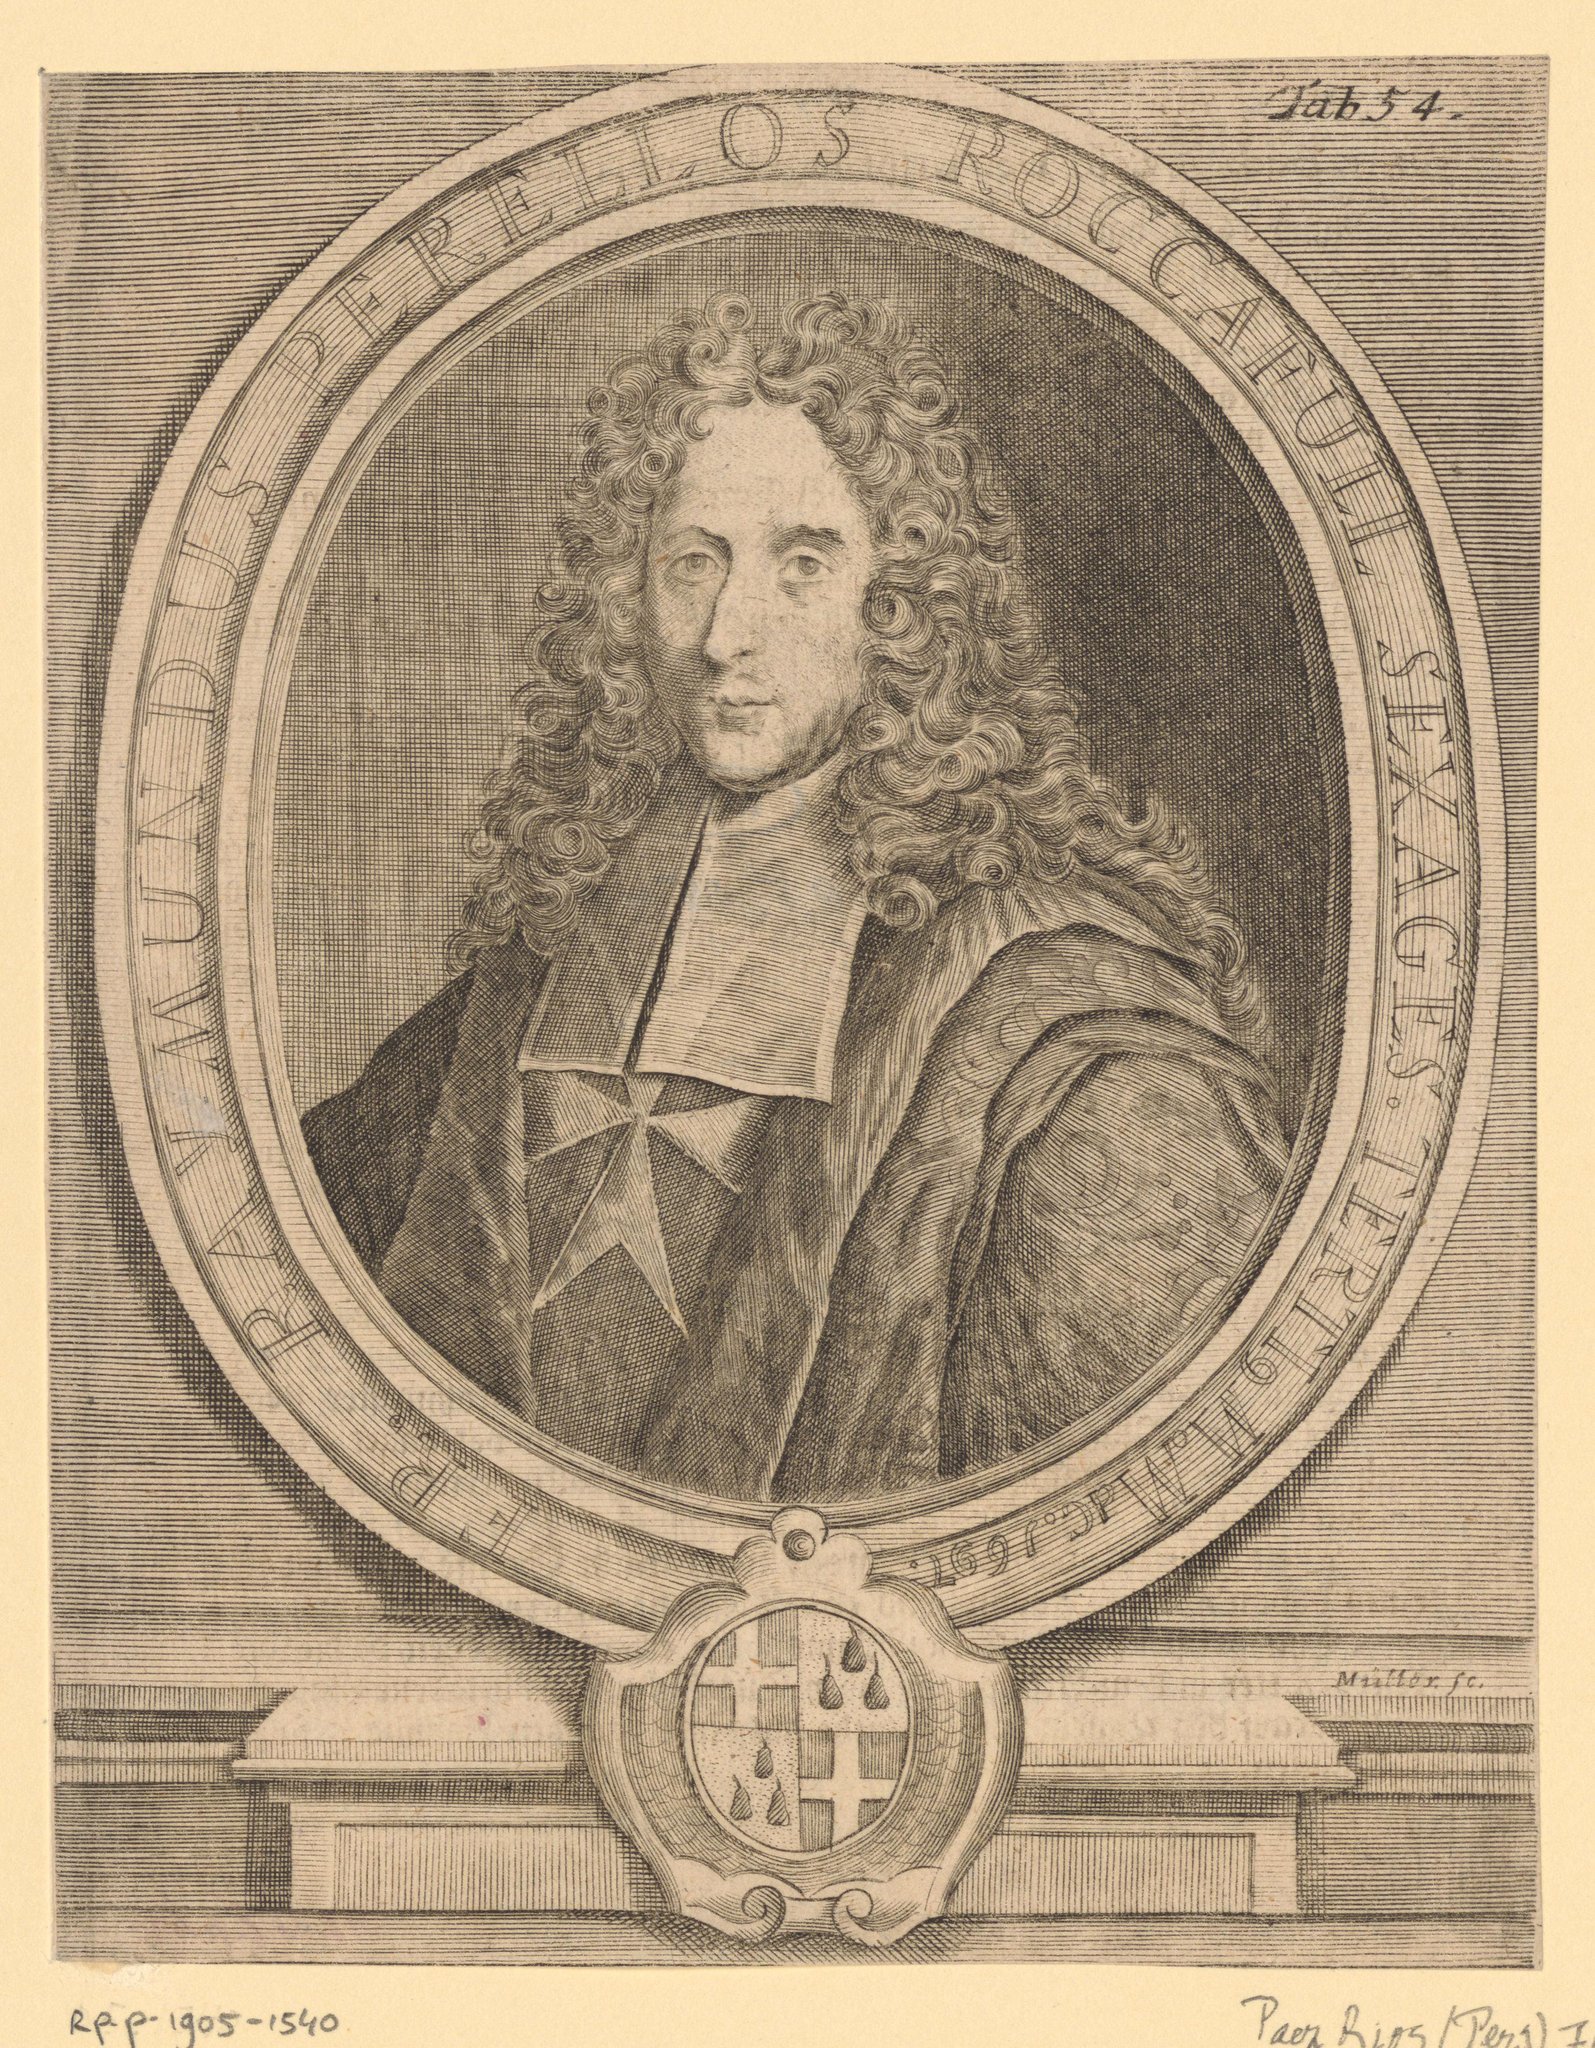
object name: print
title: Portret van Ramón Perellós y Roccaful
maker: johann sebastian müller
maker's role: print maker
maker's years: 1715-1790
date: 1735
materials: paper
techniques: engraving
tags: adult man, historical persons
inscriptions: inscription: ‘Rf.Th.E.p.67’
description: Prent waarschijnlijk uit: Myller, Angelicus Maria. Peregrinus in Jerusalem: oder ausführl. Reiß-Beschreibungen (...). Wenen en Neurenberg: Peter Conrad Monath, 1735. Eerdere staat gebruikt in: Myller, Angelicus Maria. Peregrinus in Jerusalem (...). Königs-Hoff: Mathias Adam Höger, 1732.